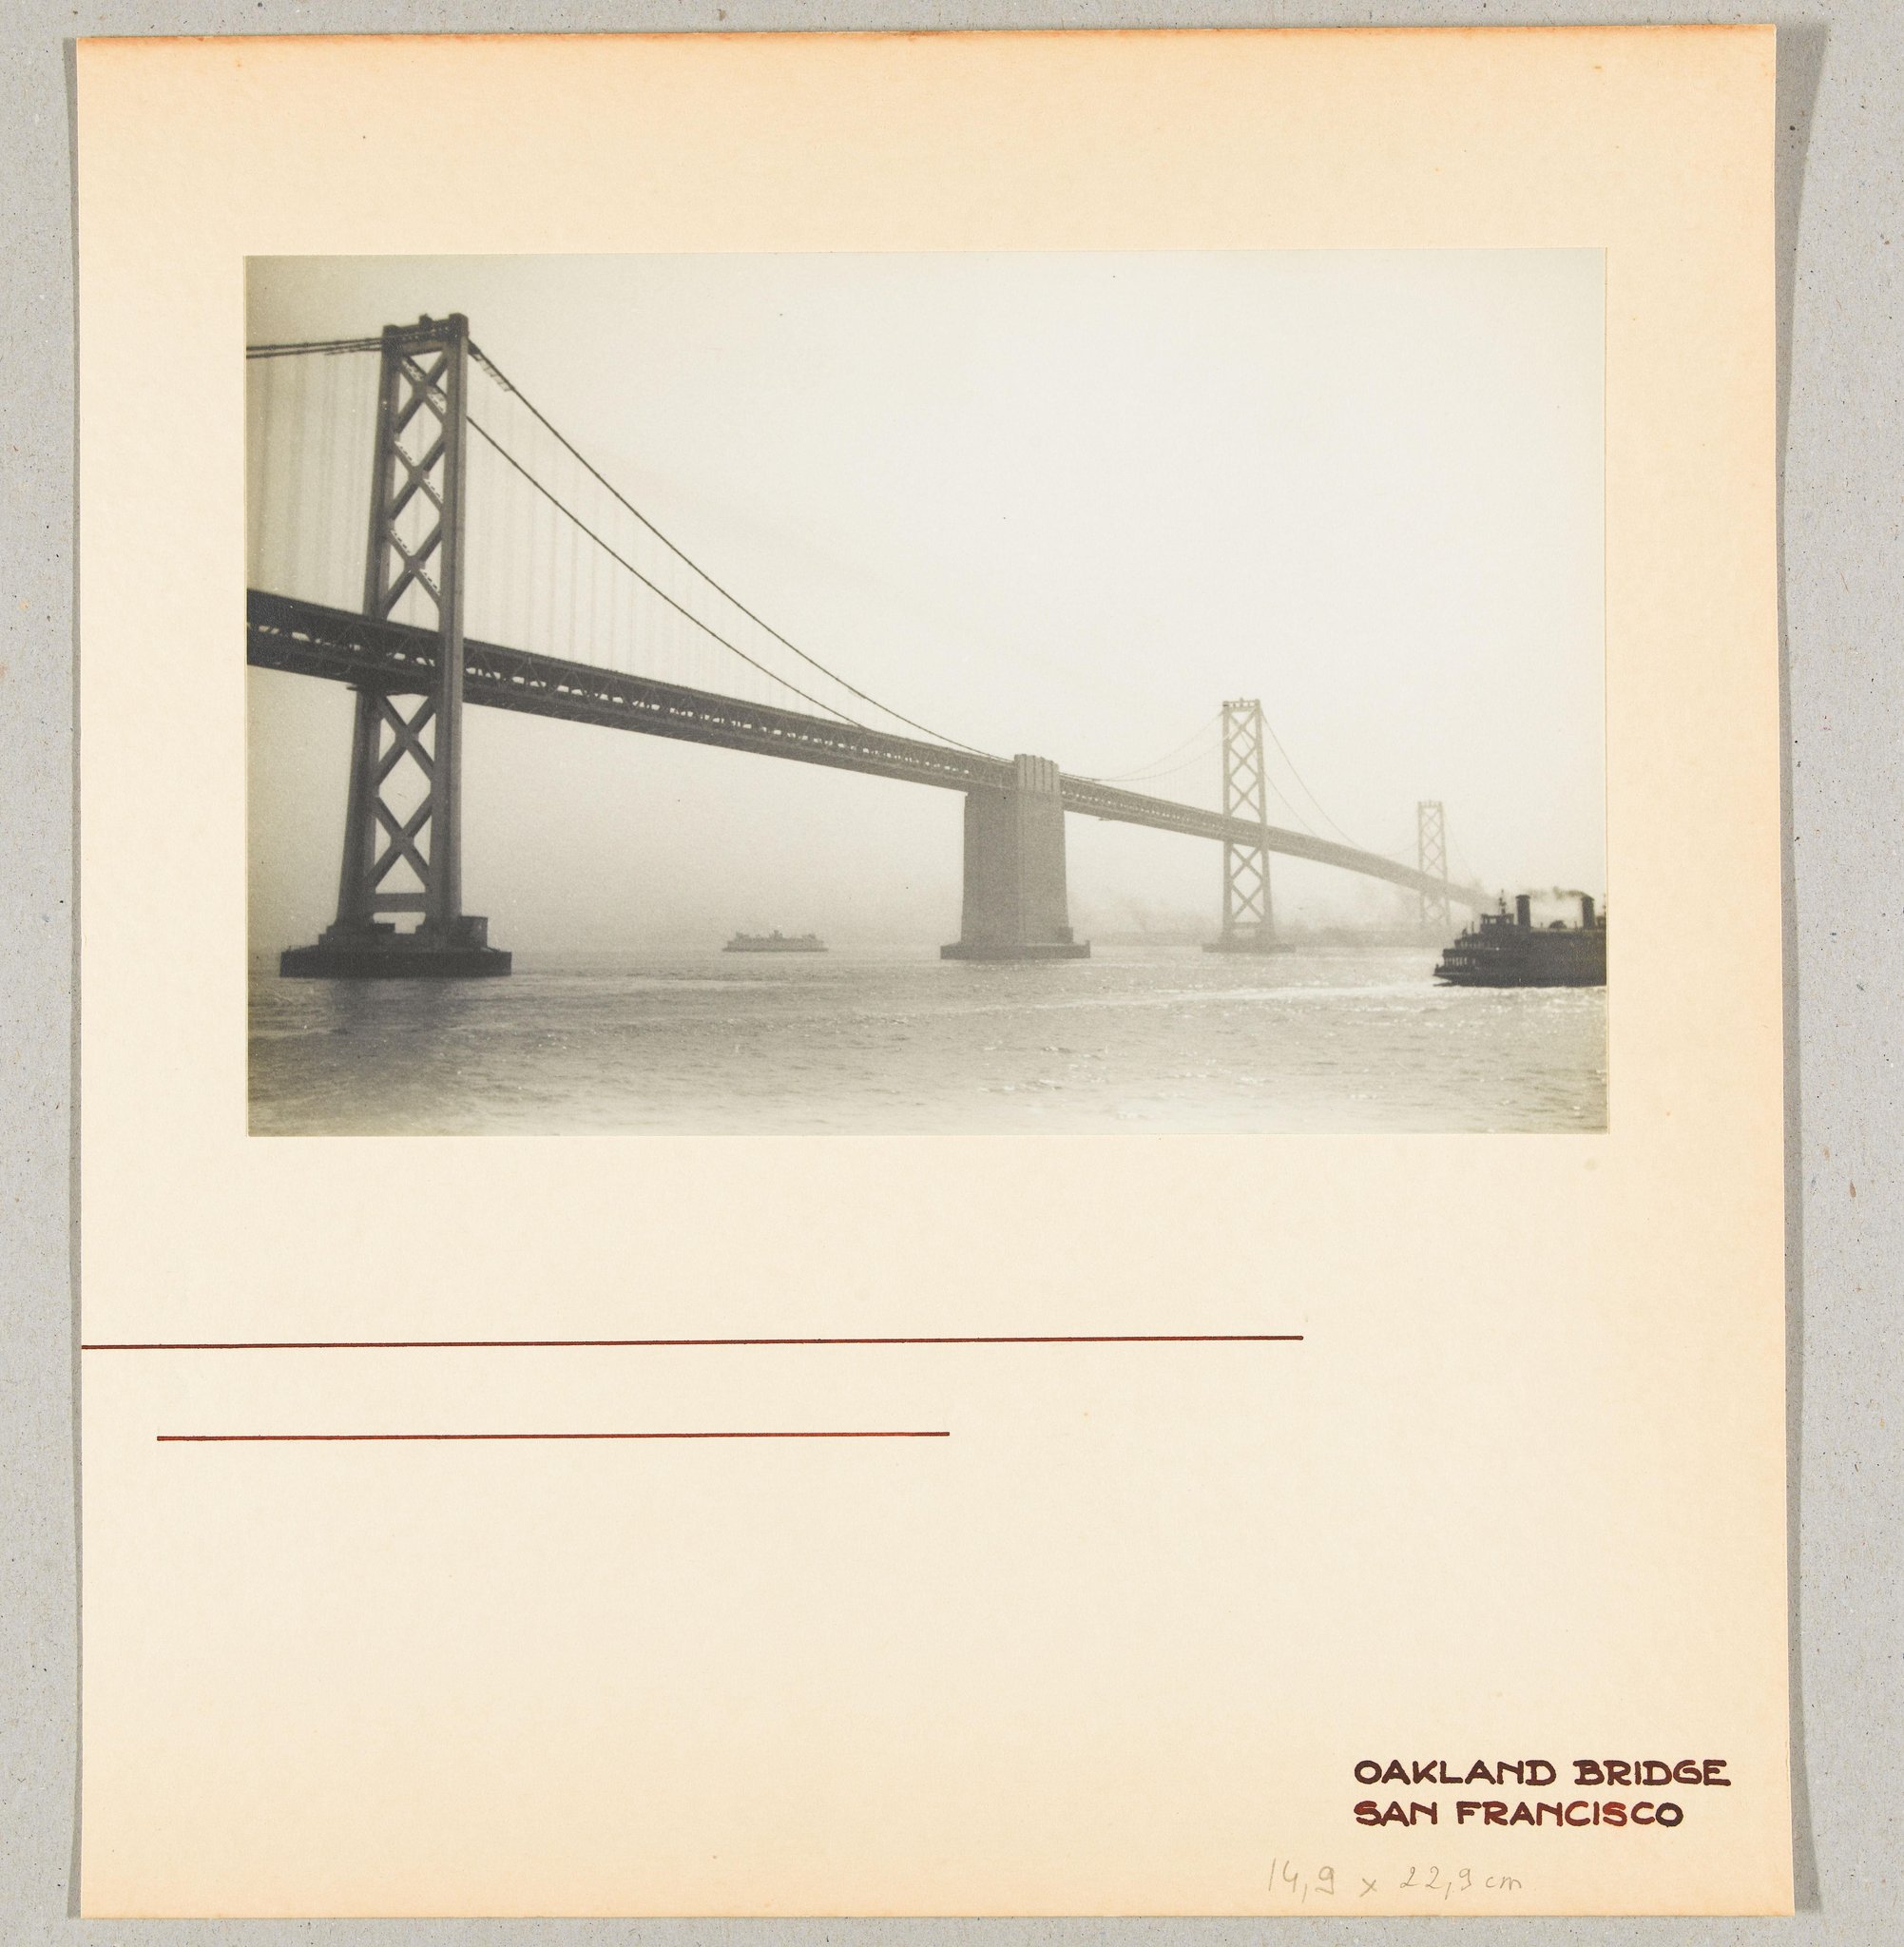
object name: photograph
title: Oakland Bridge, San Francisco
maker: wouter cool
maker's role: engineer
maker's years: 1877-1947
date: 1936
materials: cardboard, paper, photographic support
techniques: gelatin silver print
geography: united states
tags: bridge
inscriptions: title: ‘OAKLAND BRIDGE / SAN FRANCISCO’